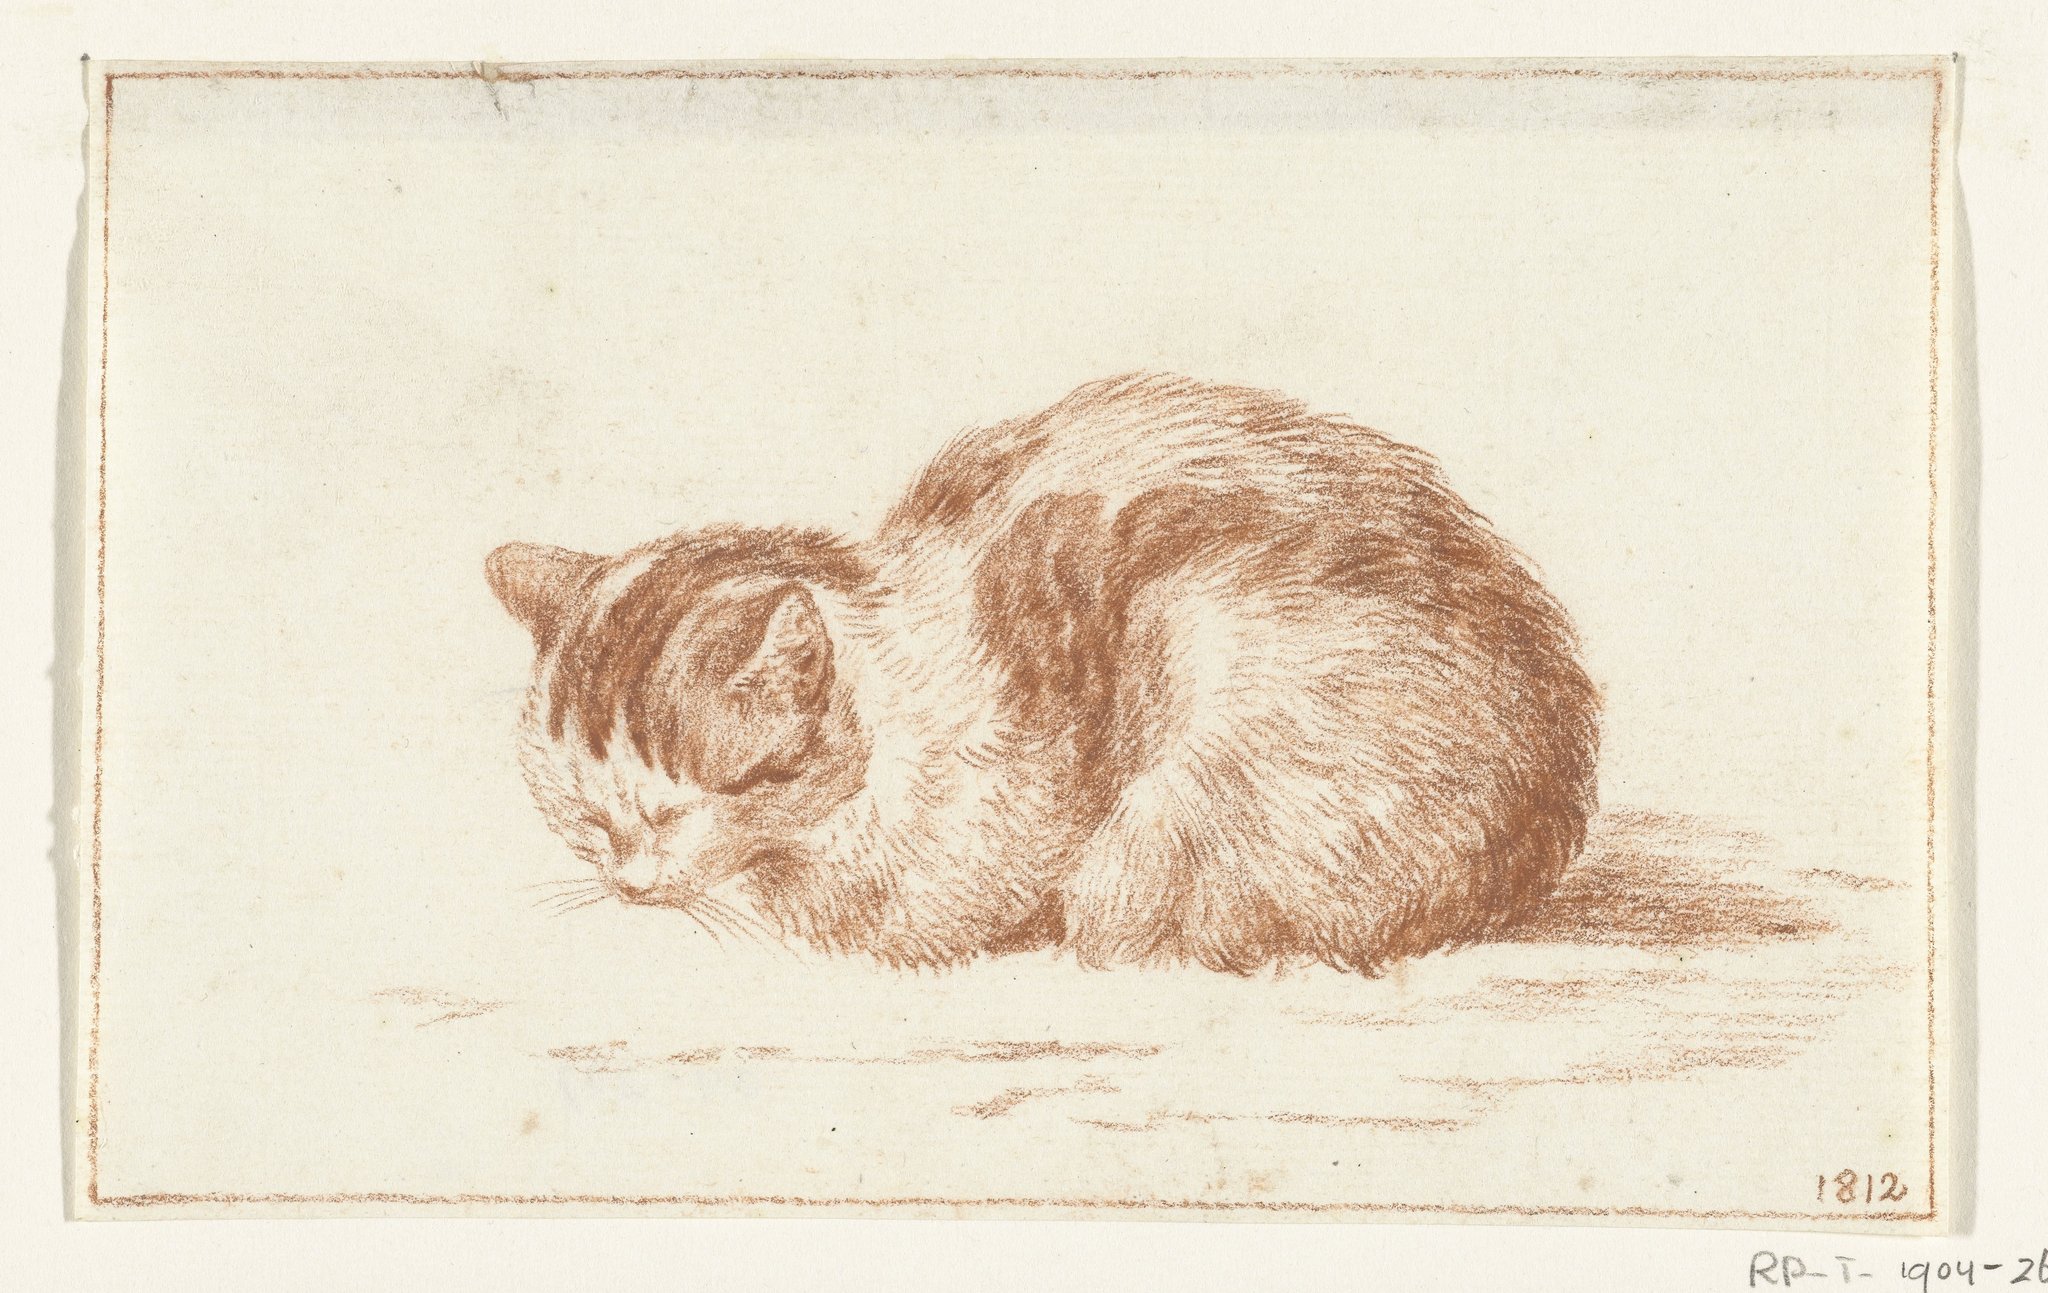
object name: drawing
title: Liggende kat, naar links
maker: jean bernard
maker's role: draughtsman, print maker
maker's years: 1765-1833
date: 1812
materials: chalk, paper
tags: cat